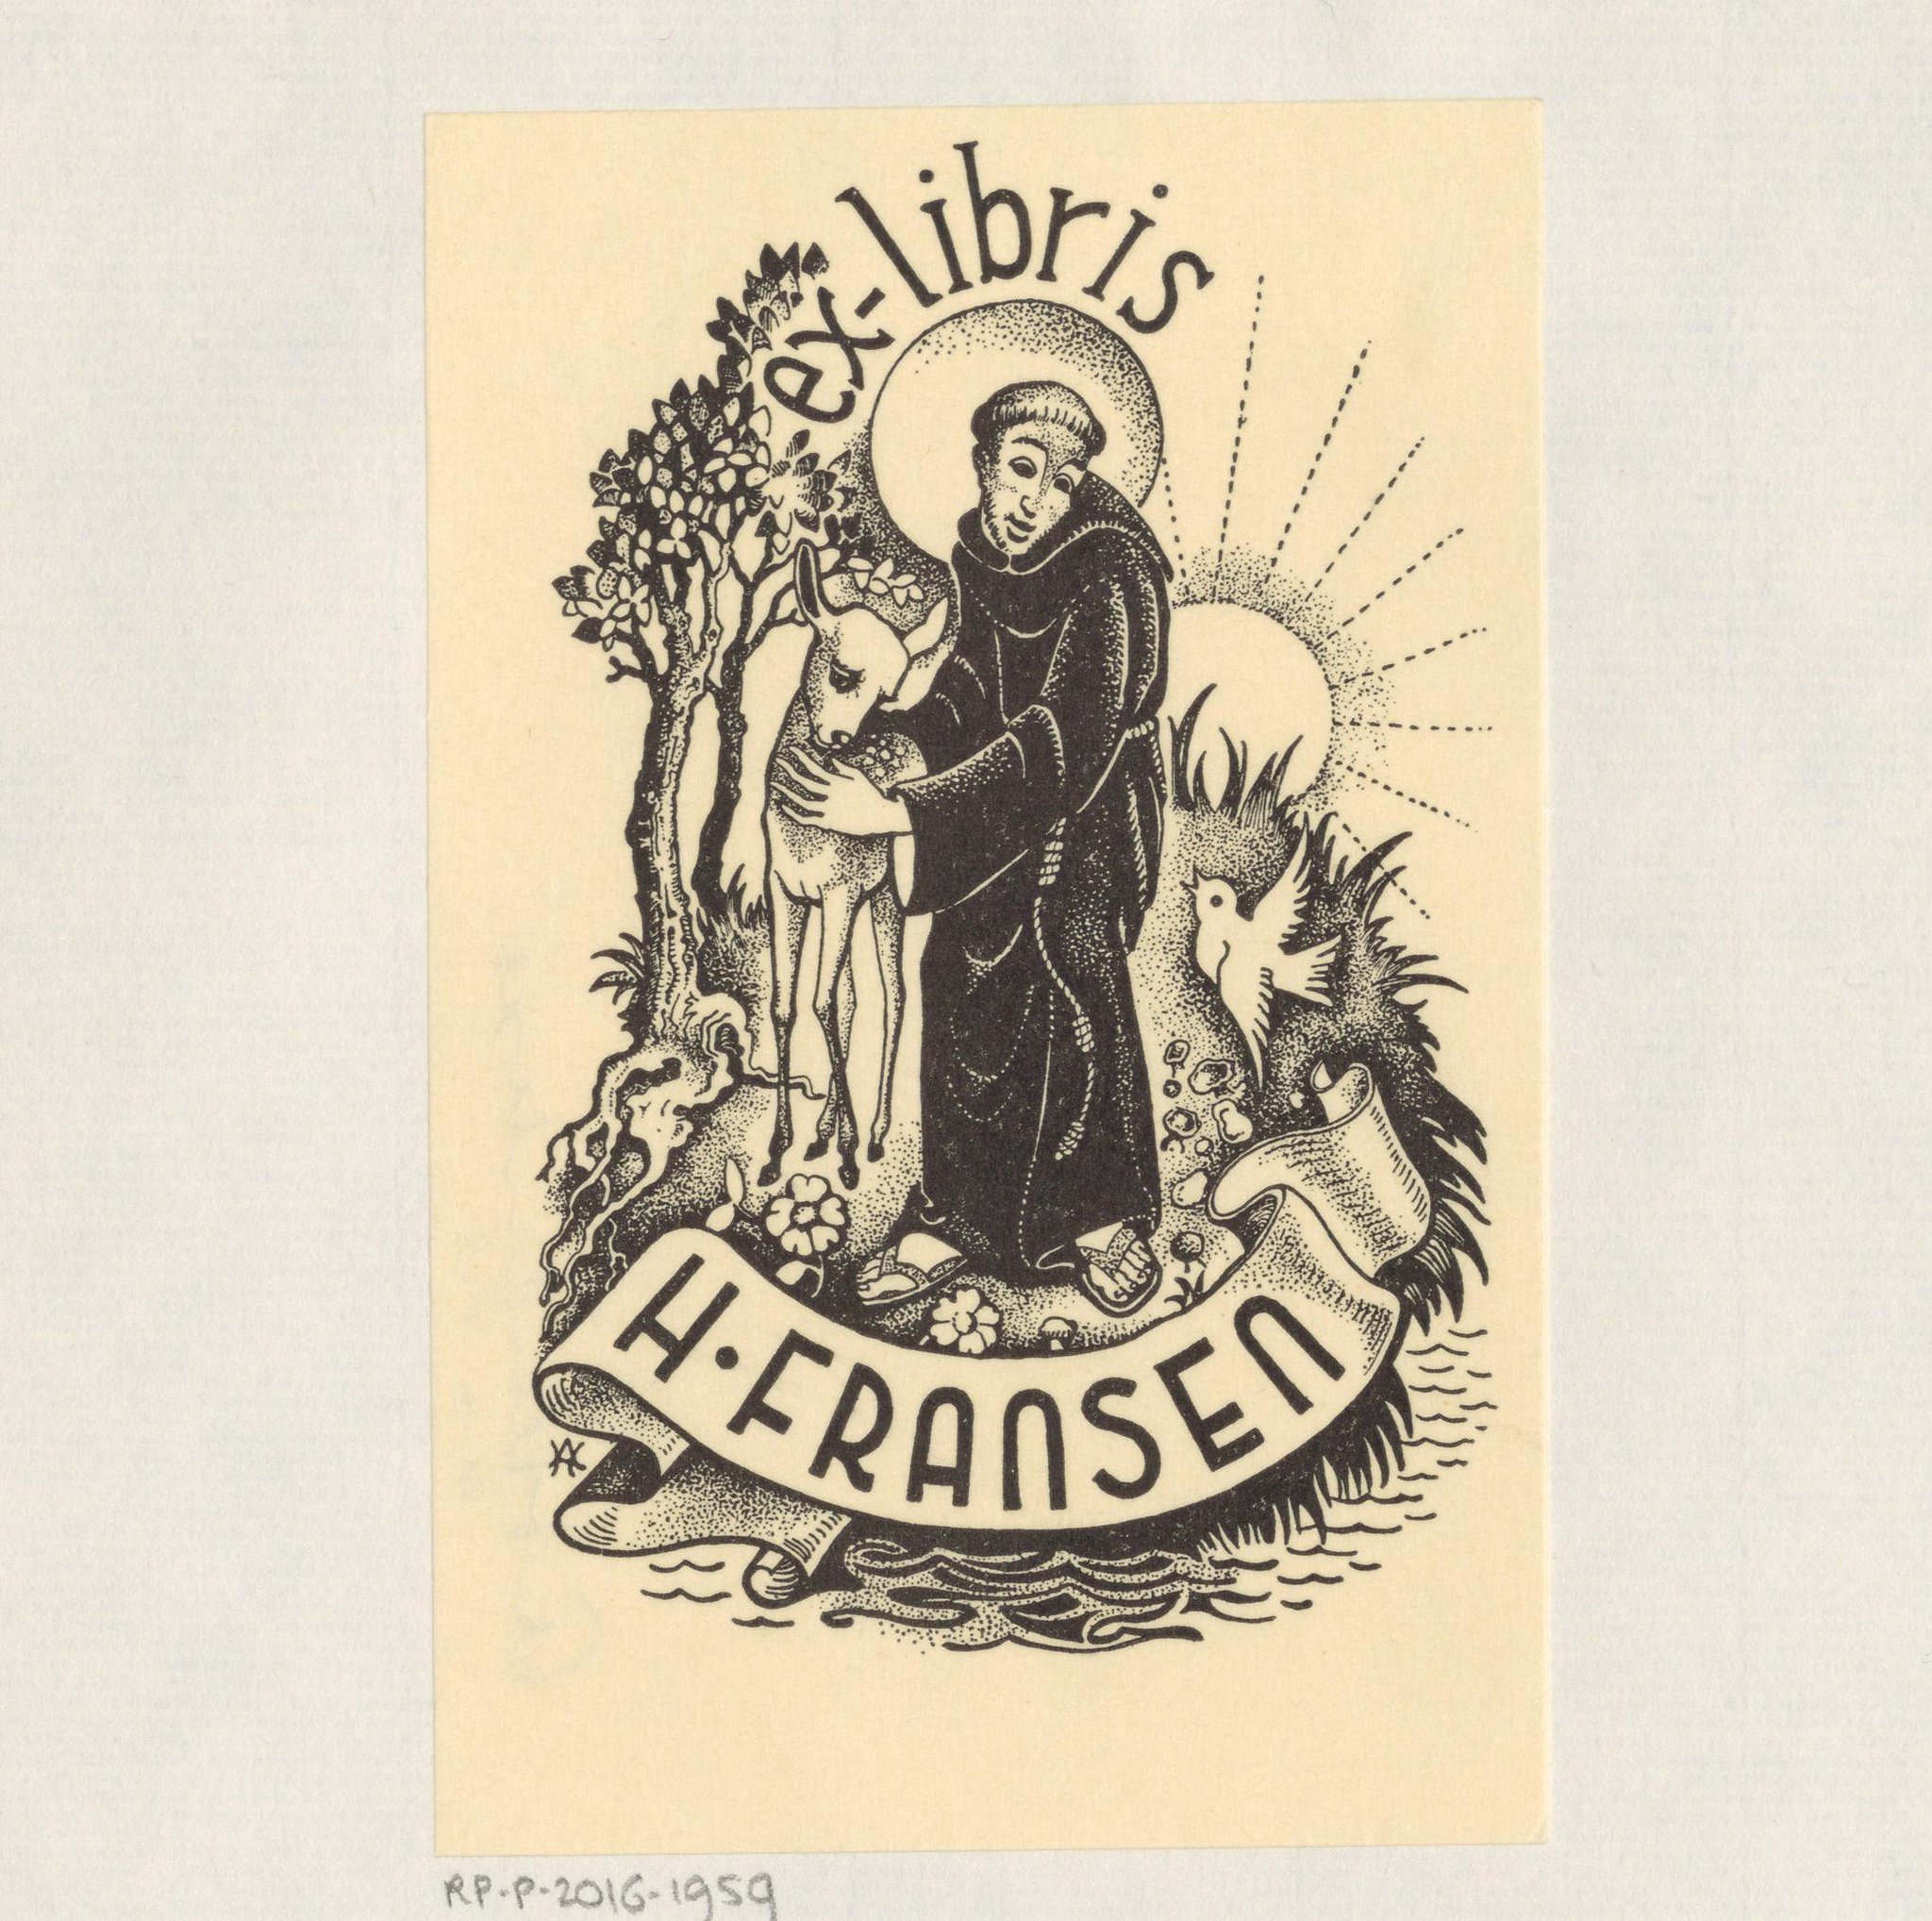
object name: bookplate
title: Ex libris van H. Fransen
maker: arend hendriks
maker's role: print maker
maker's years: 1901-1951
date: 1910-1951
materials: paper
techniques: printing block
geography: netherlands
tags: founder of the order of friars minor (franciscans), francis(cus) of assisi; possible attributes: book, crucifix, lily, skull, stigmata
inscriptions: signature: ‘A. Hendrikxs’